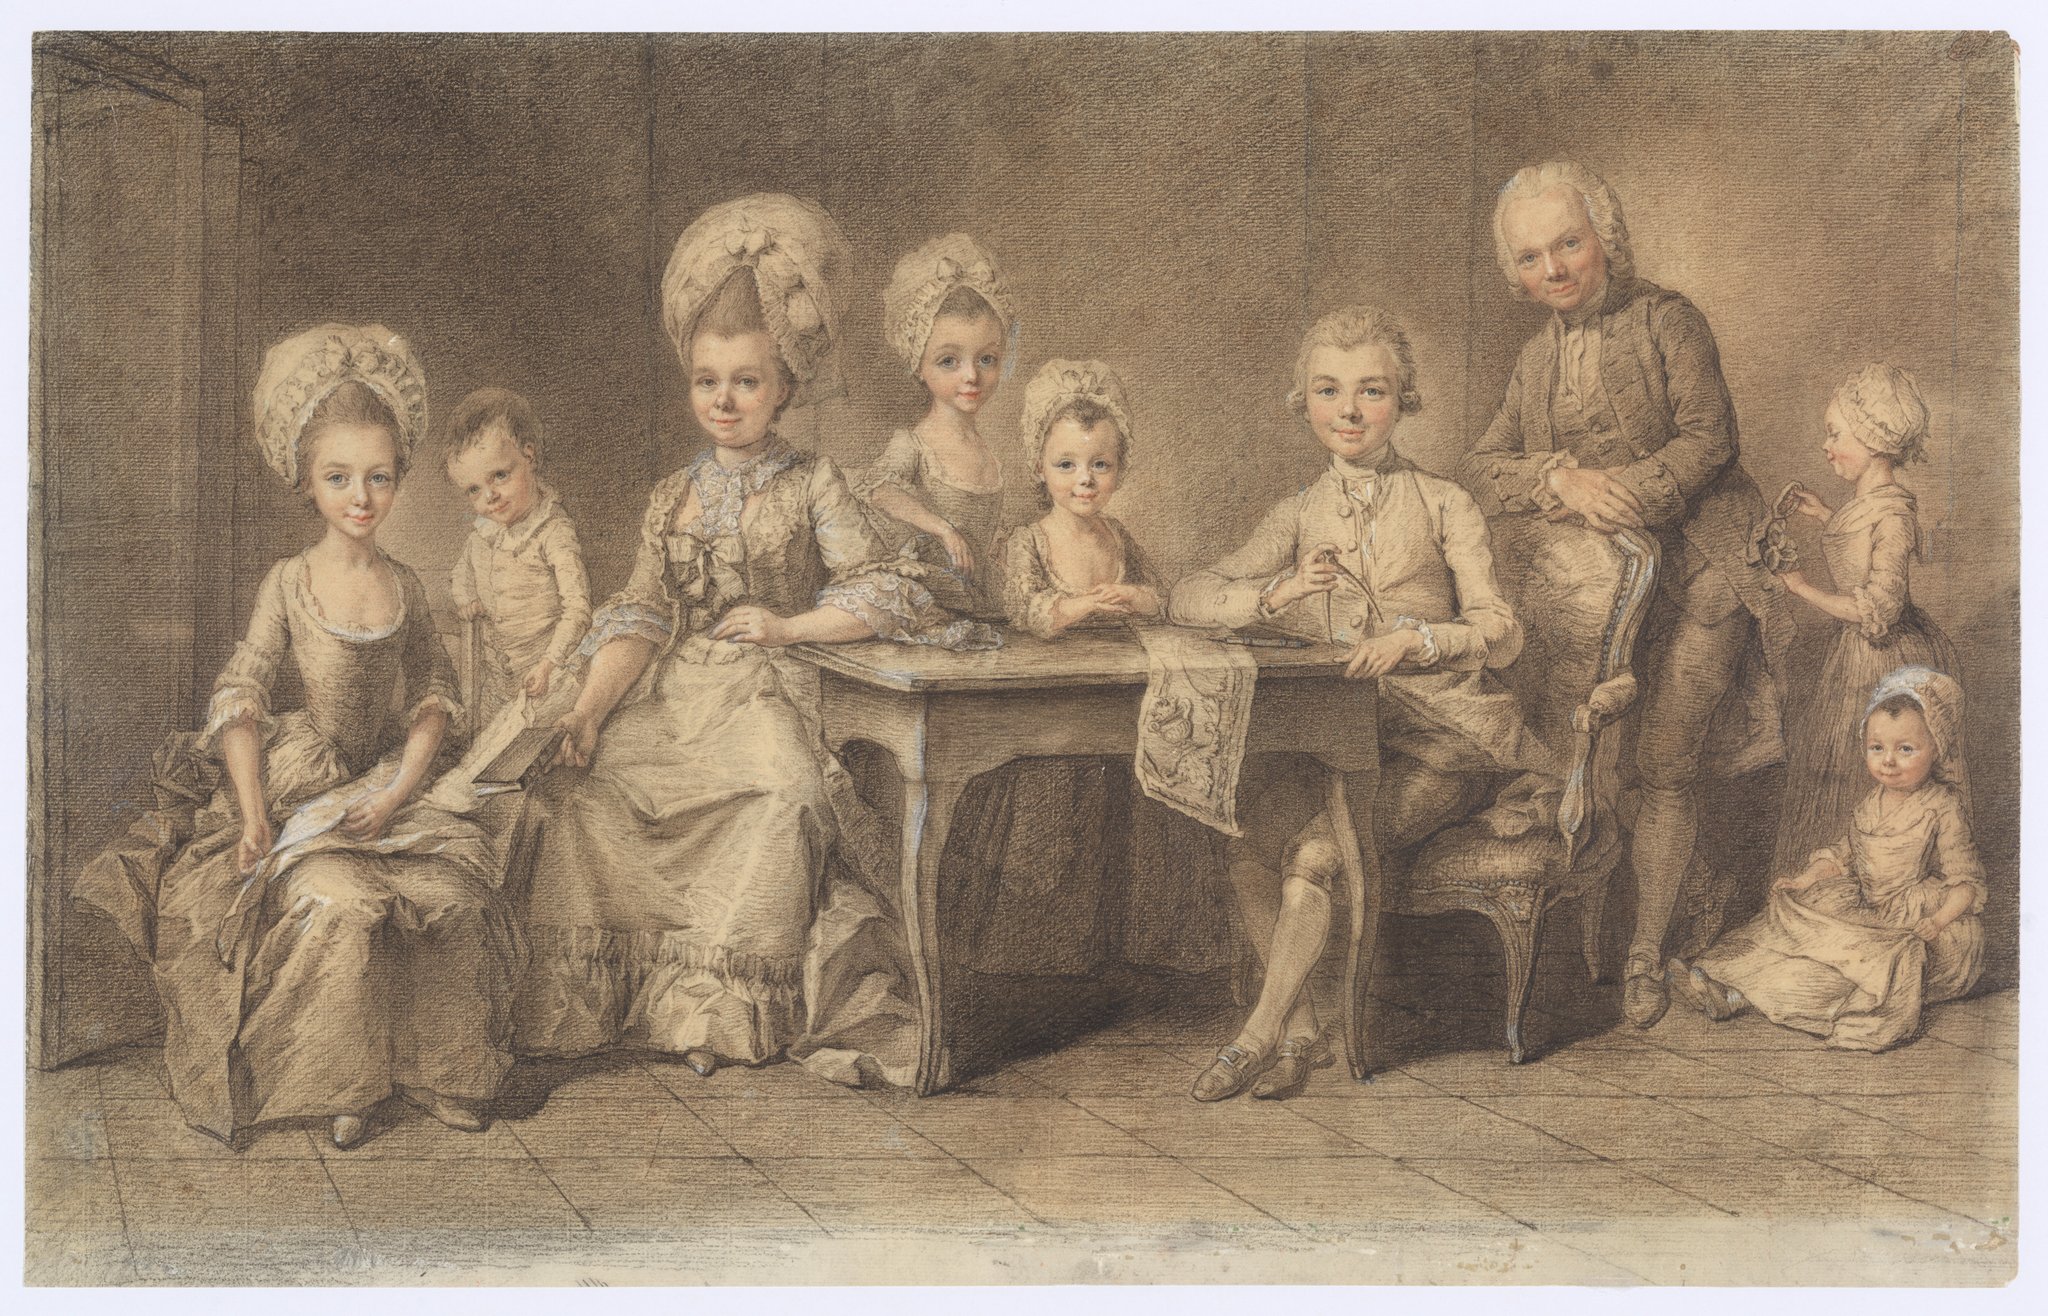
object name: drawing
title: Family Portrait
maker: georg david matthieu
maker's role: artist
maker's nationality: german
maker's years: 1737-1778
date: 1737-1778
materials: chalk, gouache, pastel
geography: germany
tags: children,men,portraits,women,family